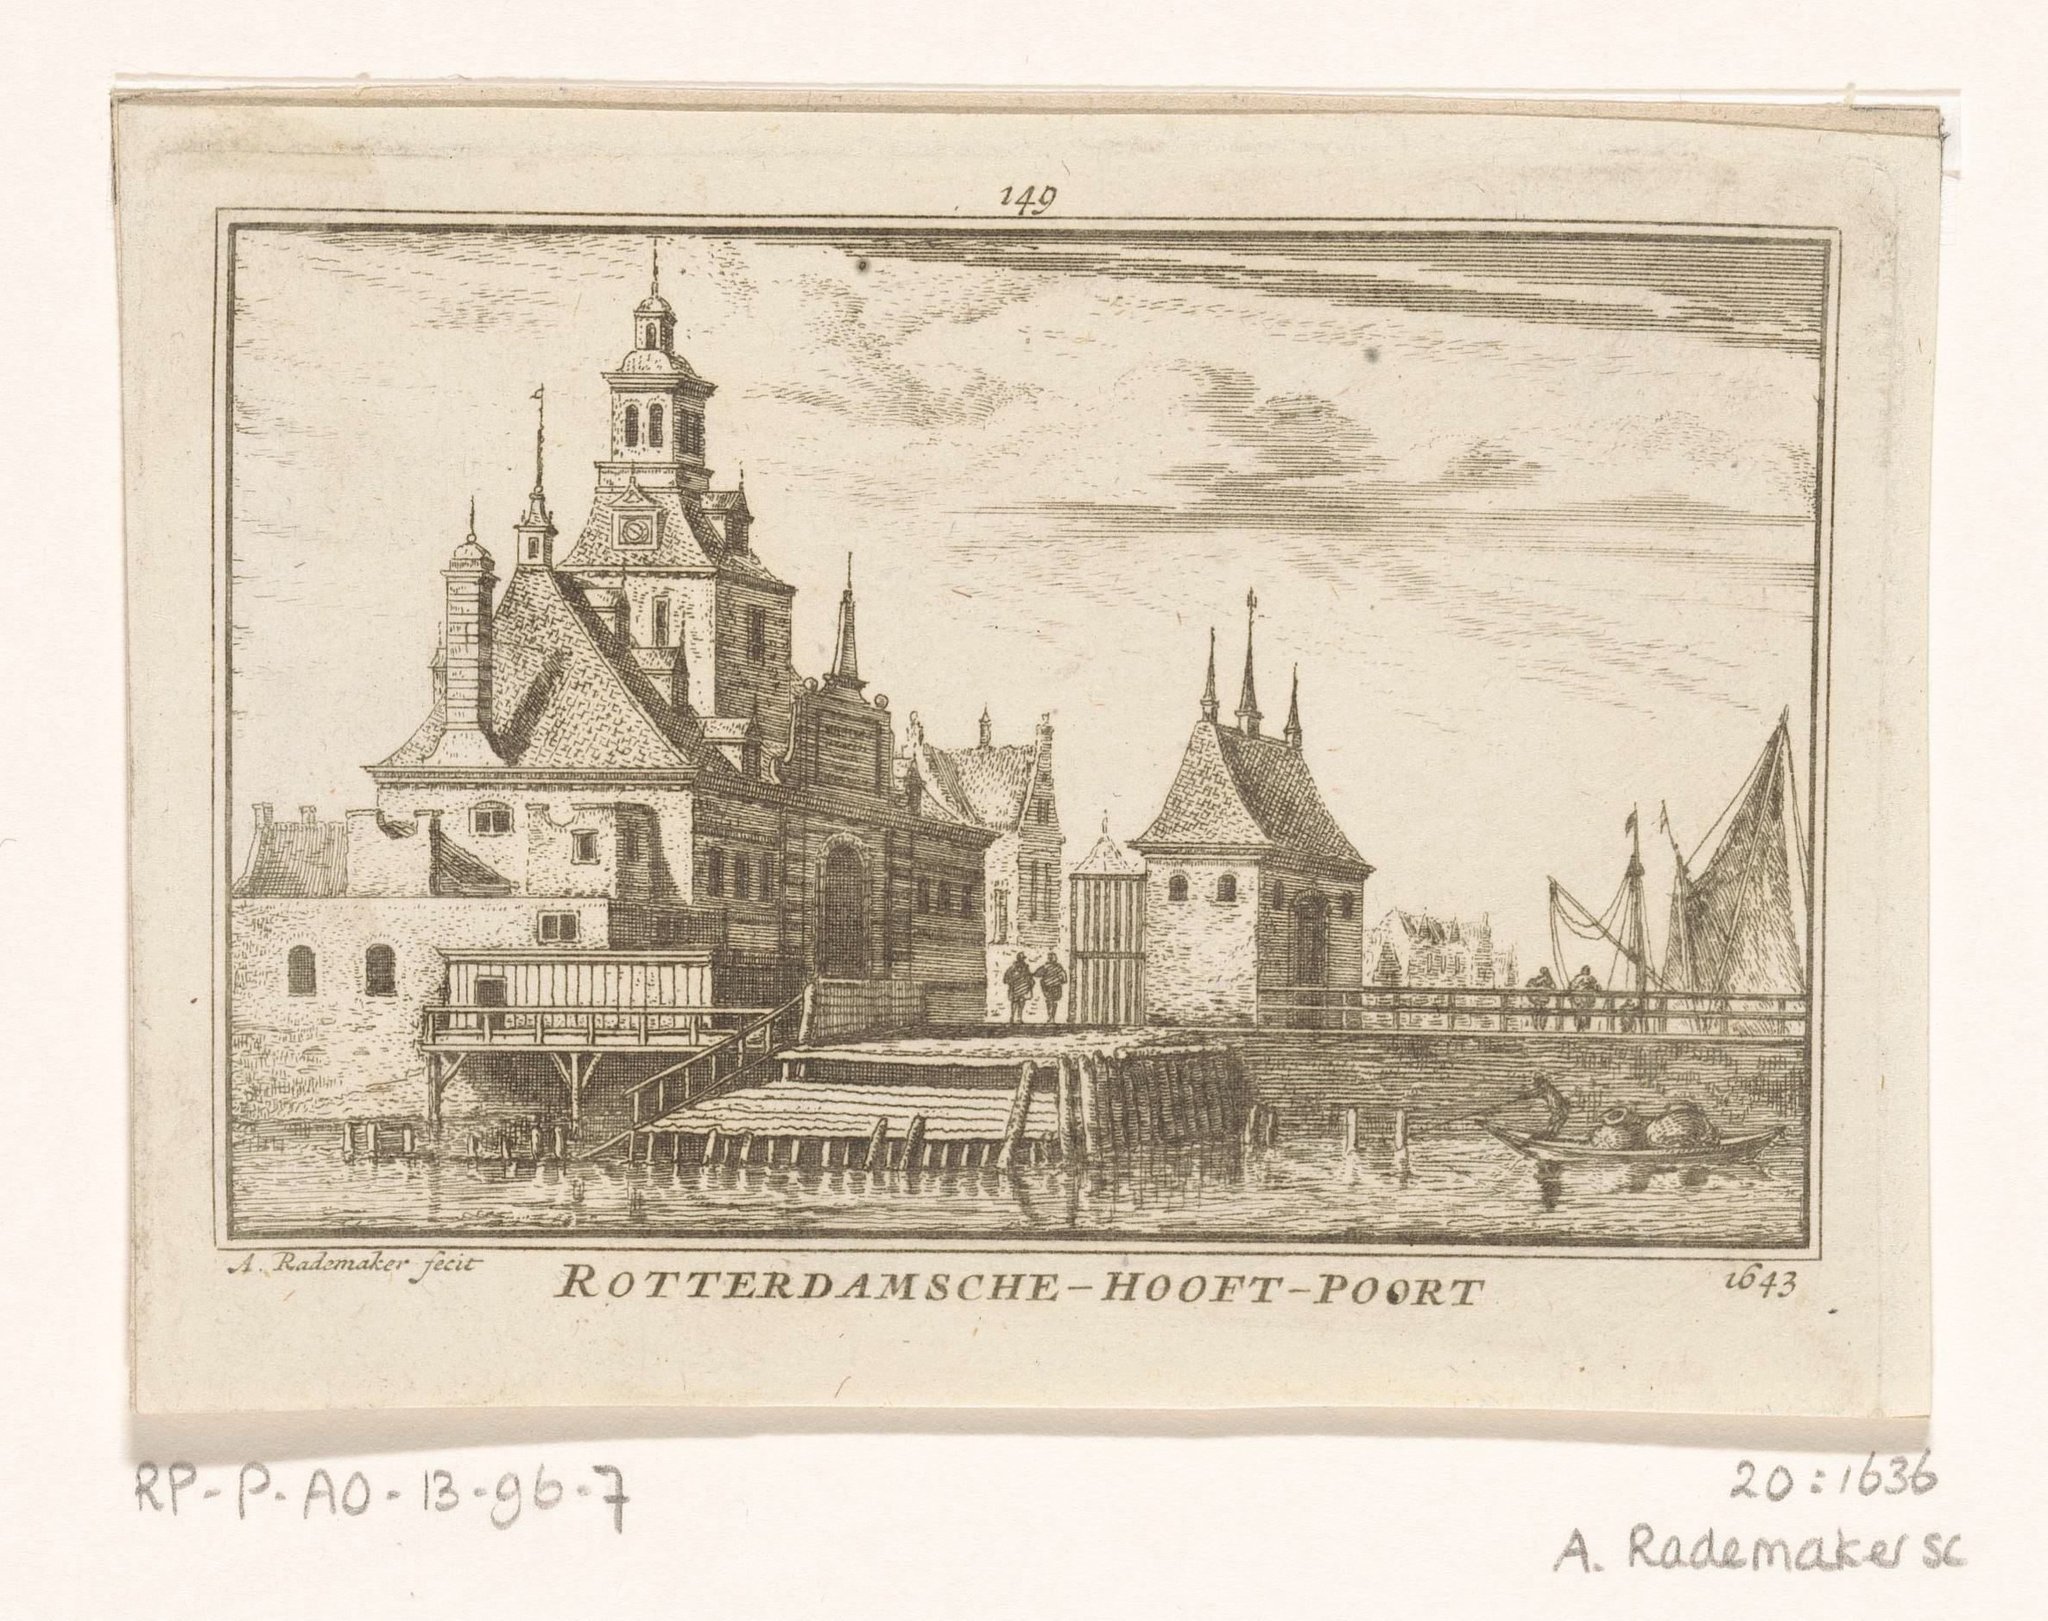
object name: print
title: Rotterdamsche-Hooft-Poort 1643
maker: abraham rademaker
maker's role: draughtsman, print maker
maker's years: 1676-1735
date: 1725-1803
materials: paper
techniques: engraving, etching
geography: amsterdam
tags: sailing-ship, sailing-boat, rowing-boat, canoe, etc., city-gate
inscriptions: collector's mark: Lugt 2233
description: Prent ook gebruikt in: Rademaker, Abraham. Kabinet van Nederlandsche outheden en gezichten: vervat in 300 konstplaaten (…). 2 delen. Amsterdam: Willem Barents, 1725, dl. 1, ill. 149. Na 1725 is deze prent nog in verschillende heruitgaven verschenen, uitgegeven in 1727-1733, 1770-1771 en 1792-1803. Uit welke uitgave het huidige exemplaar precies komt is niet na te gaan.